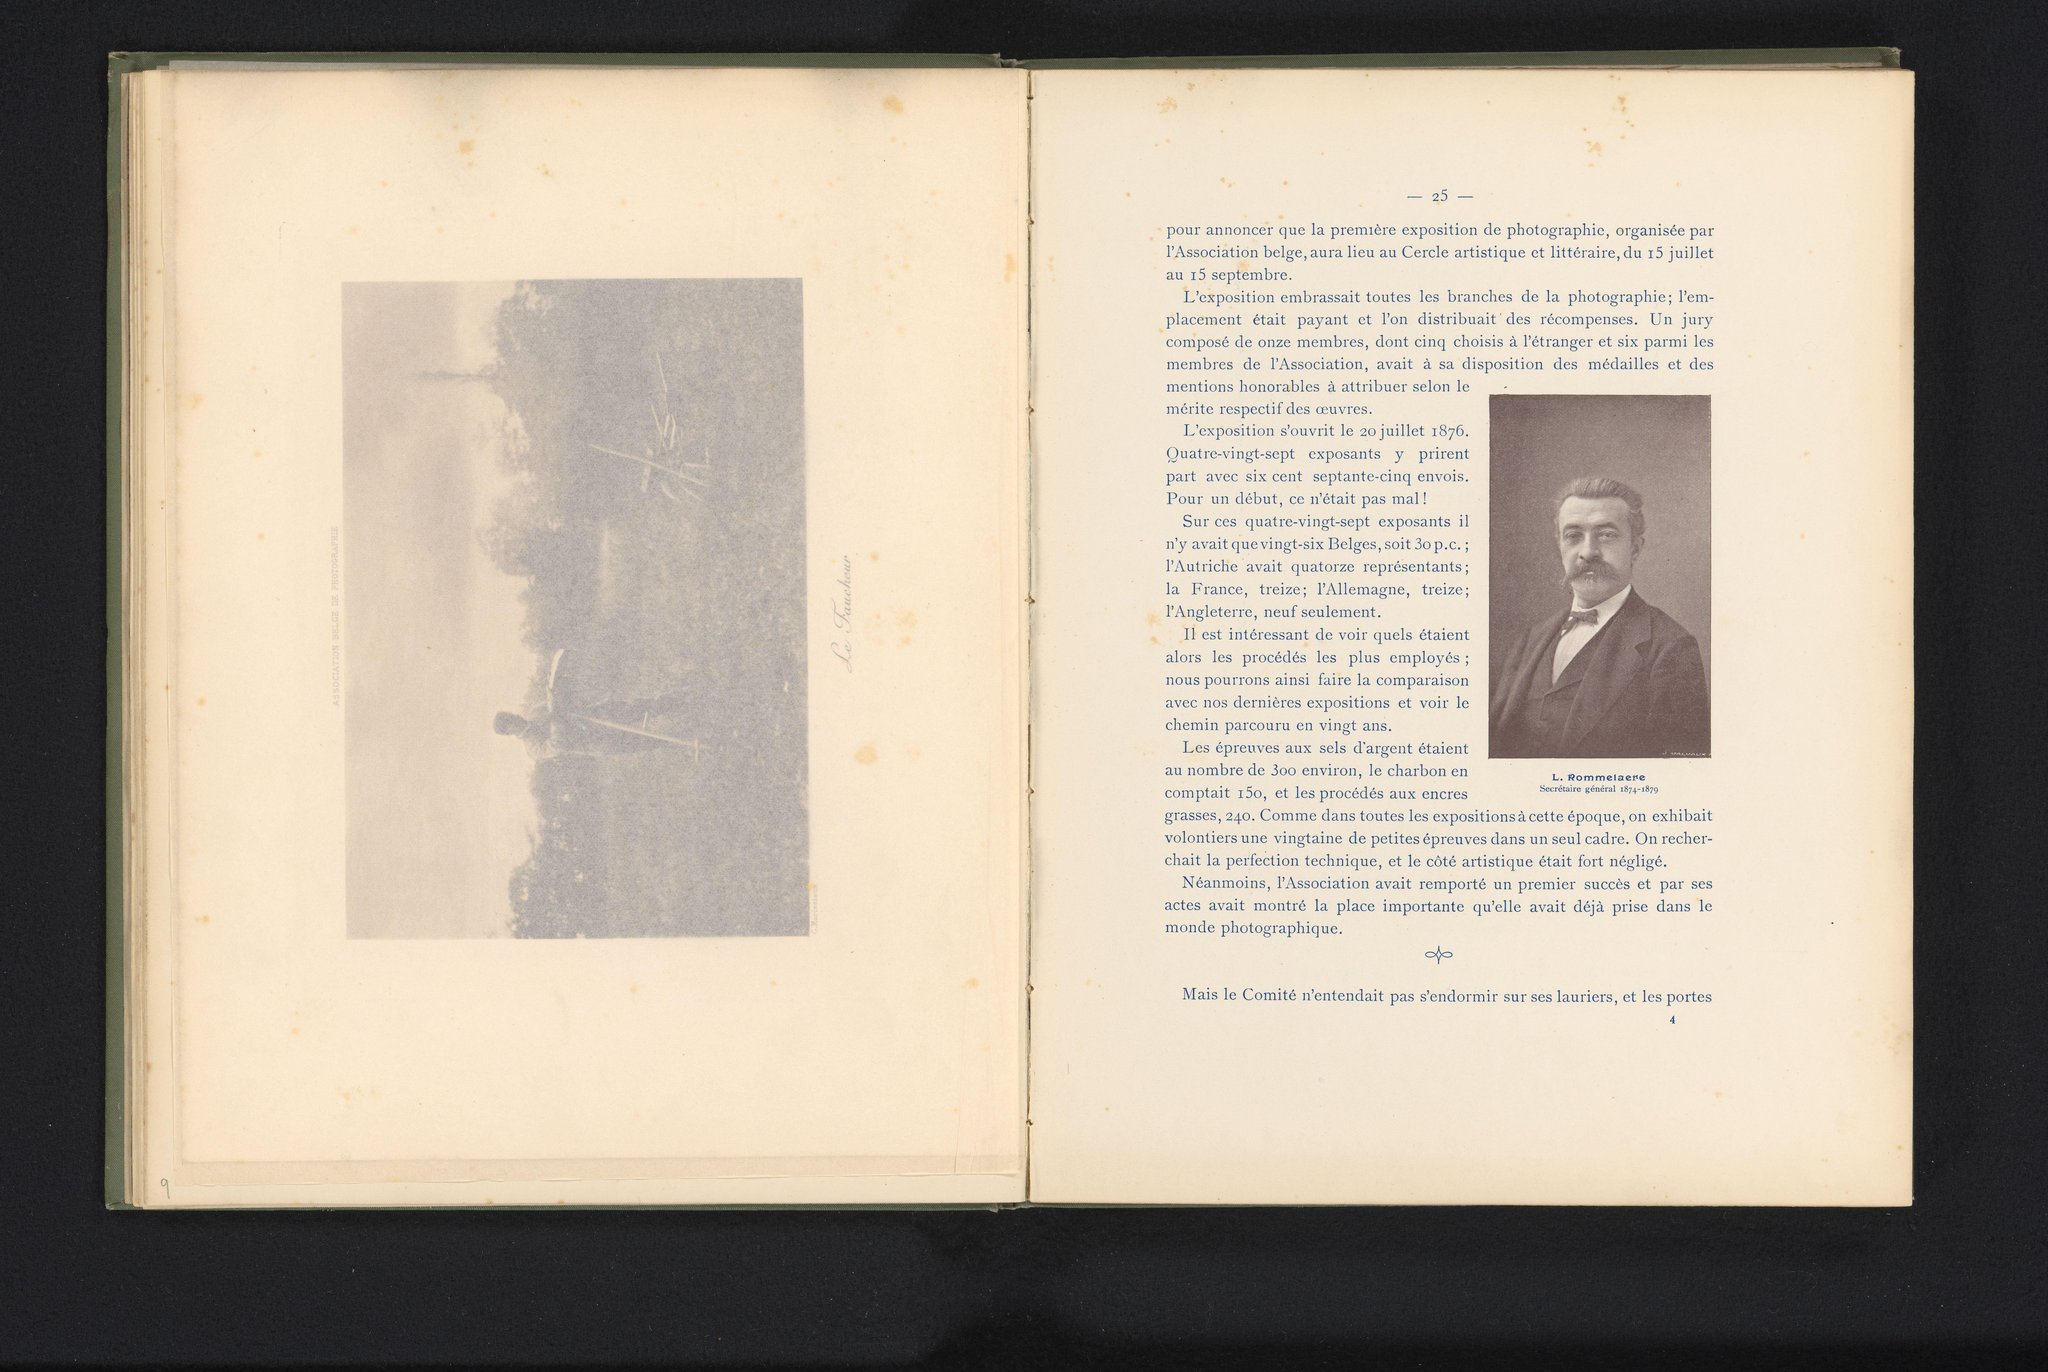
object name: page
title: Portret van L. Rommelaere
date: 1893-1898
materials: paper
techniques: autotype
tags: ghent, brussels, léonce rommelaere, historical persons